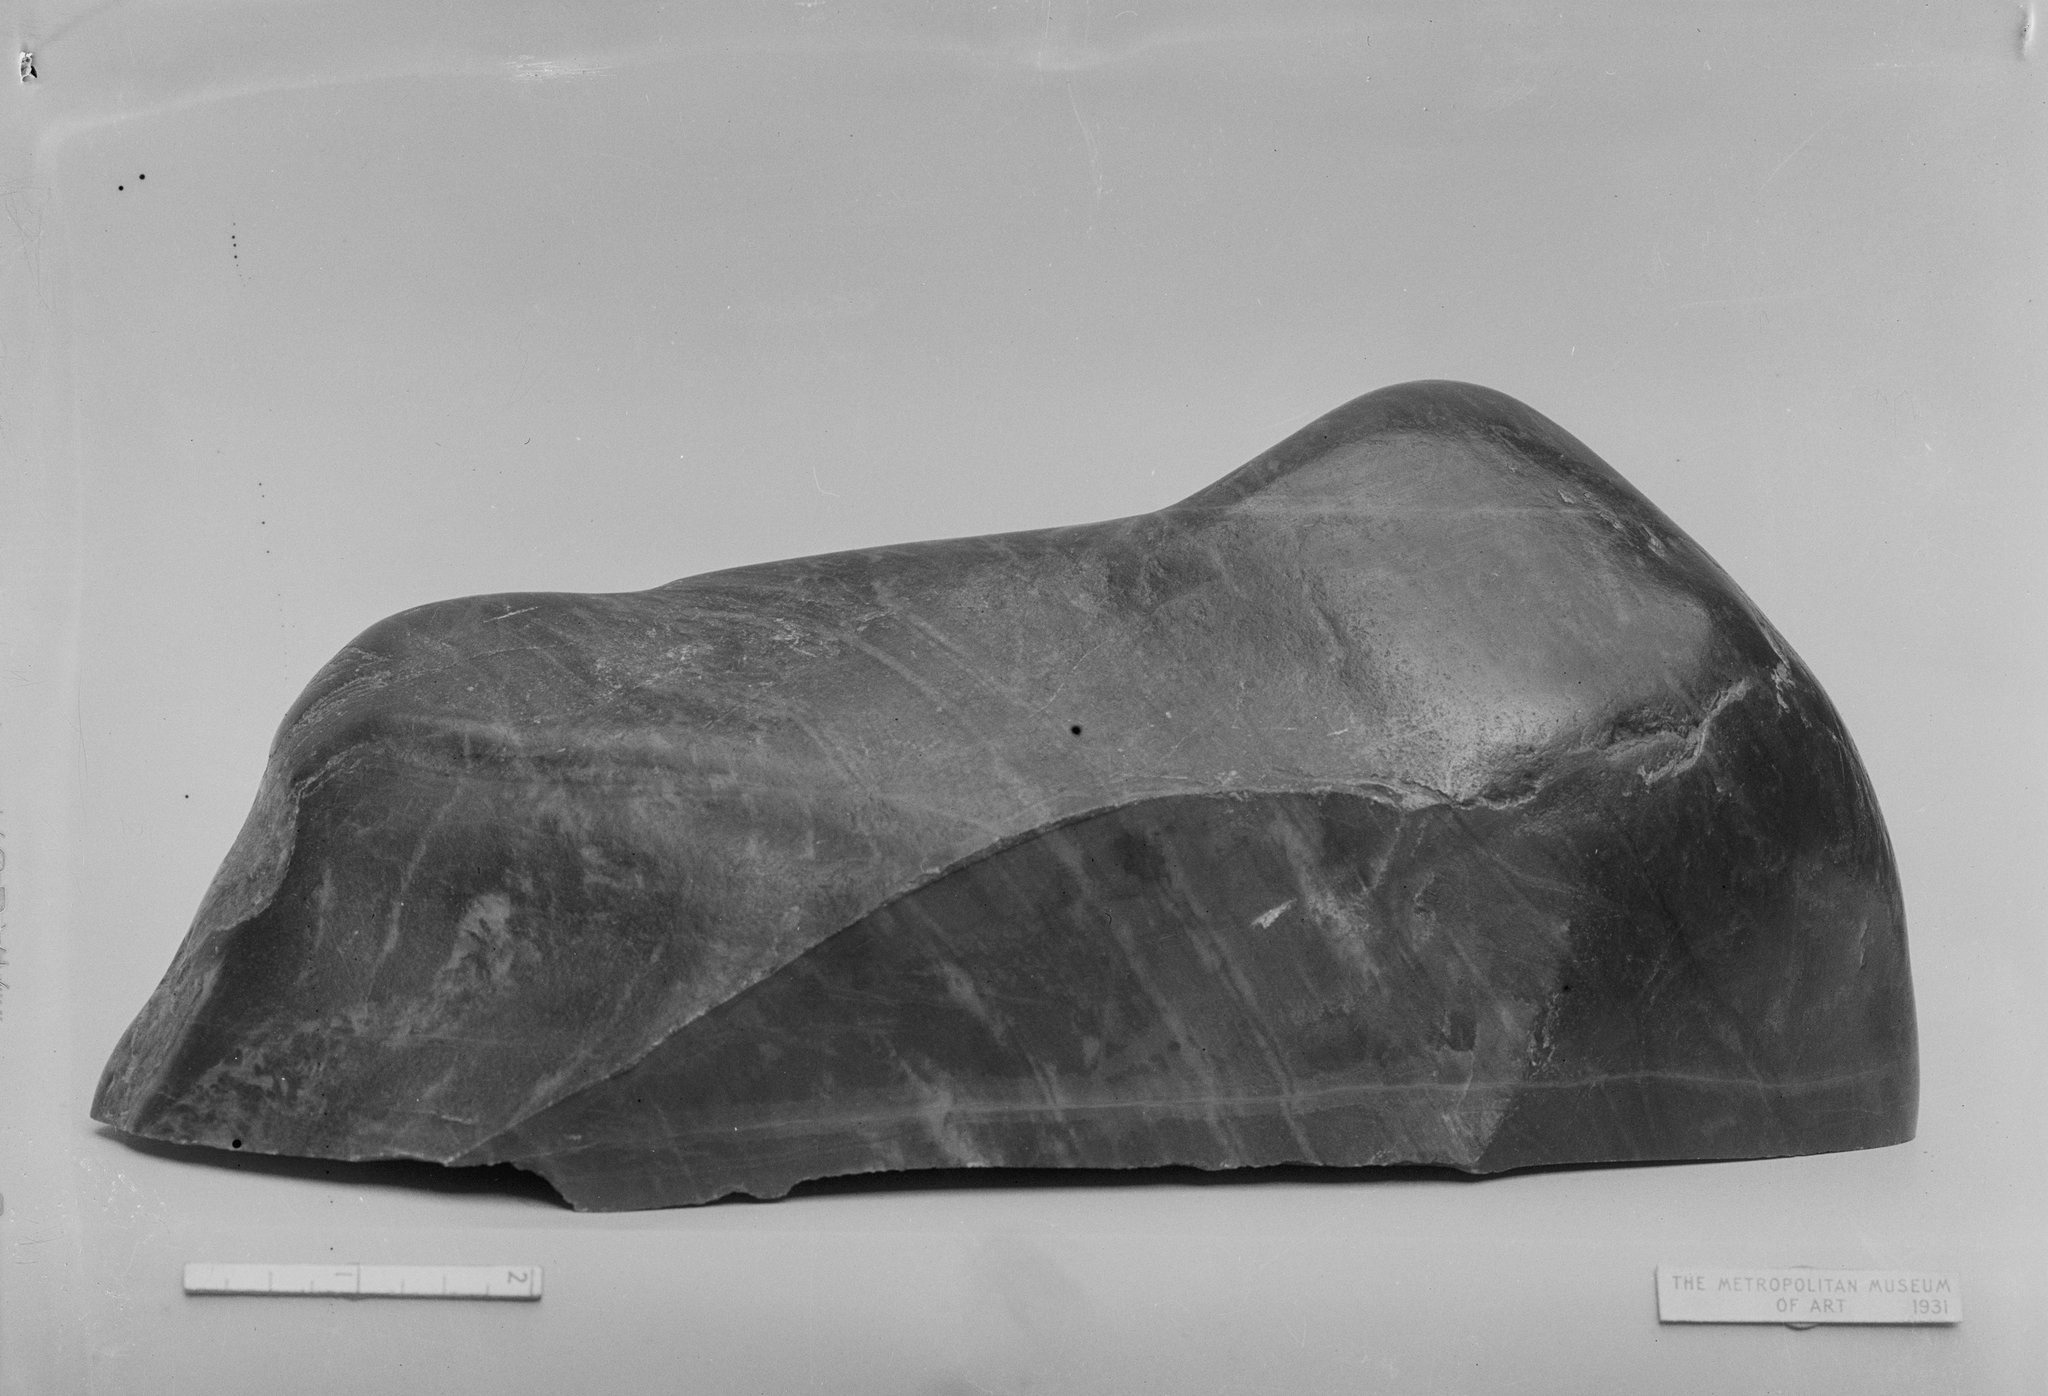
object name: fragment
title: Fragment of a Boulder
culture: chinese or turkestani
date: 1902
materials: jade